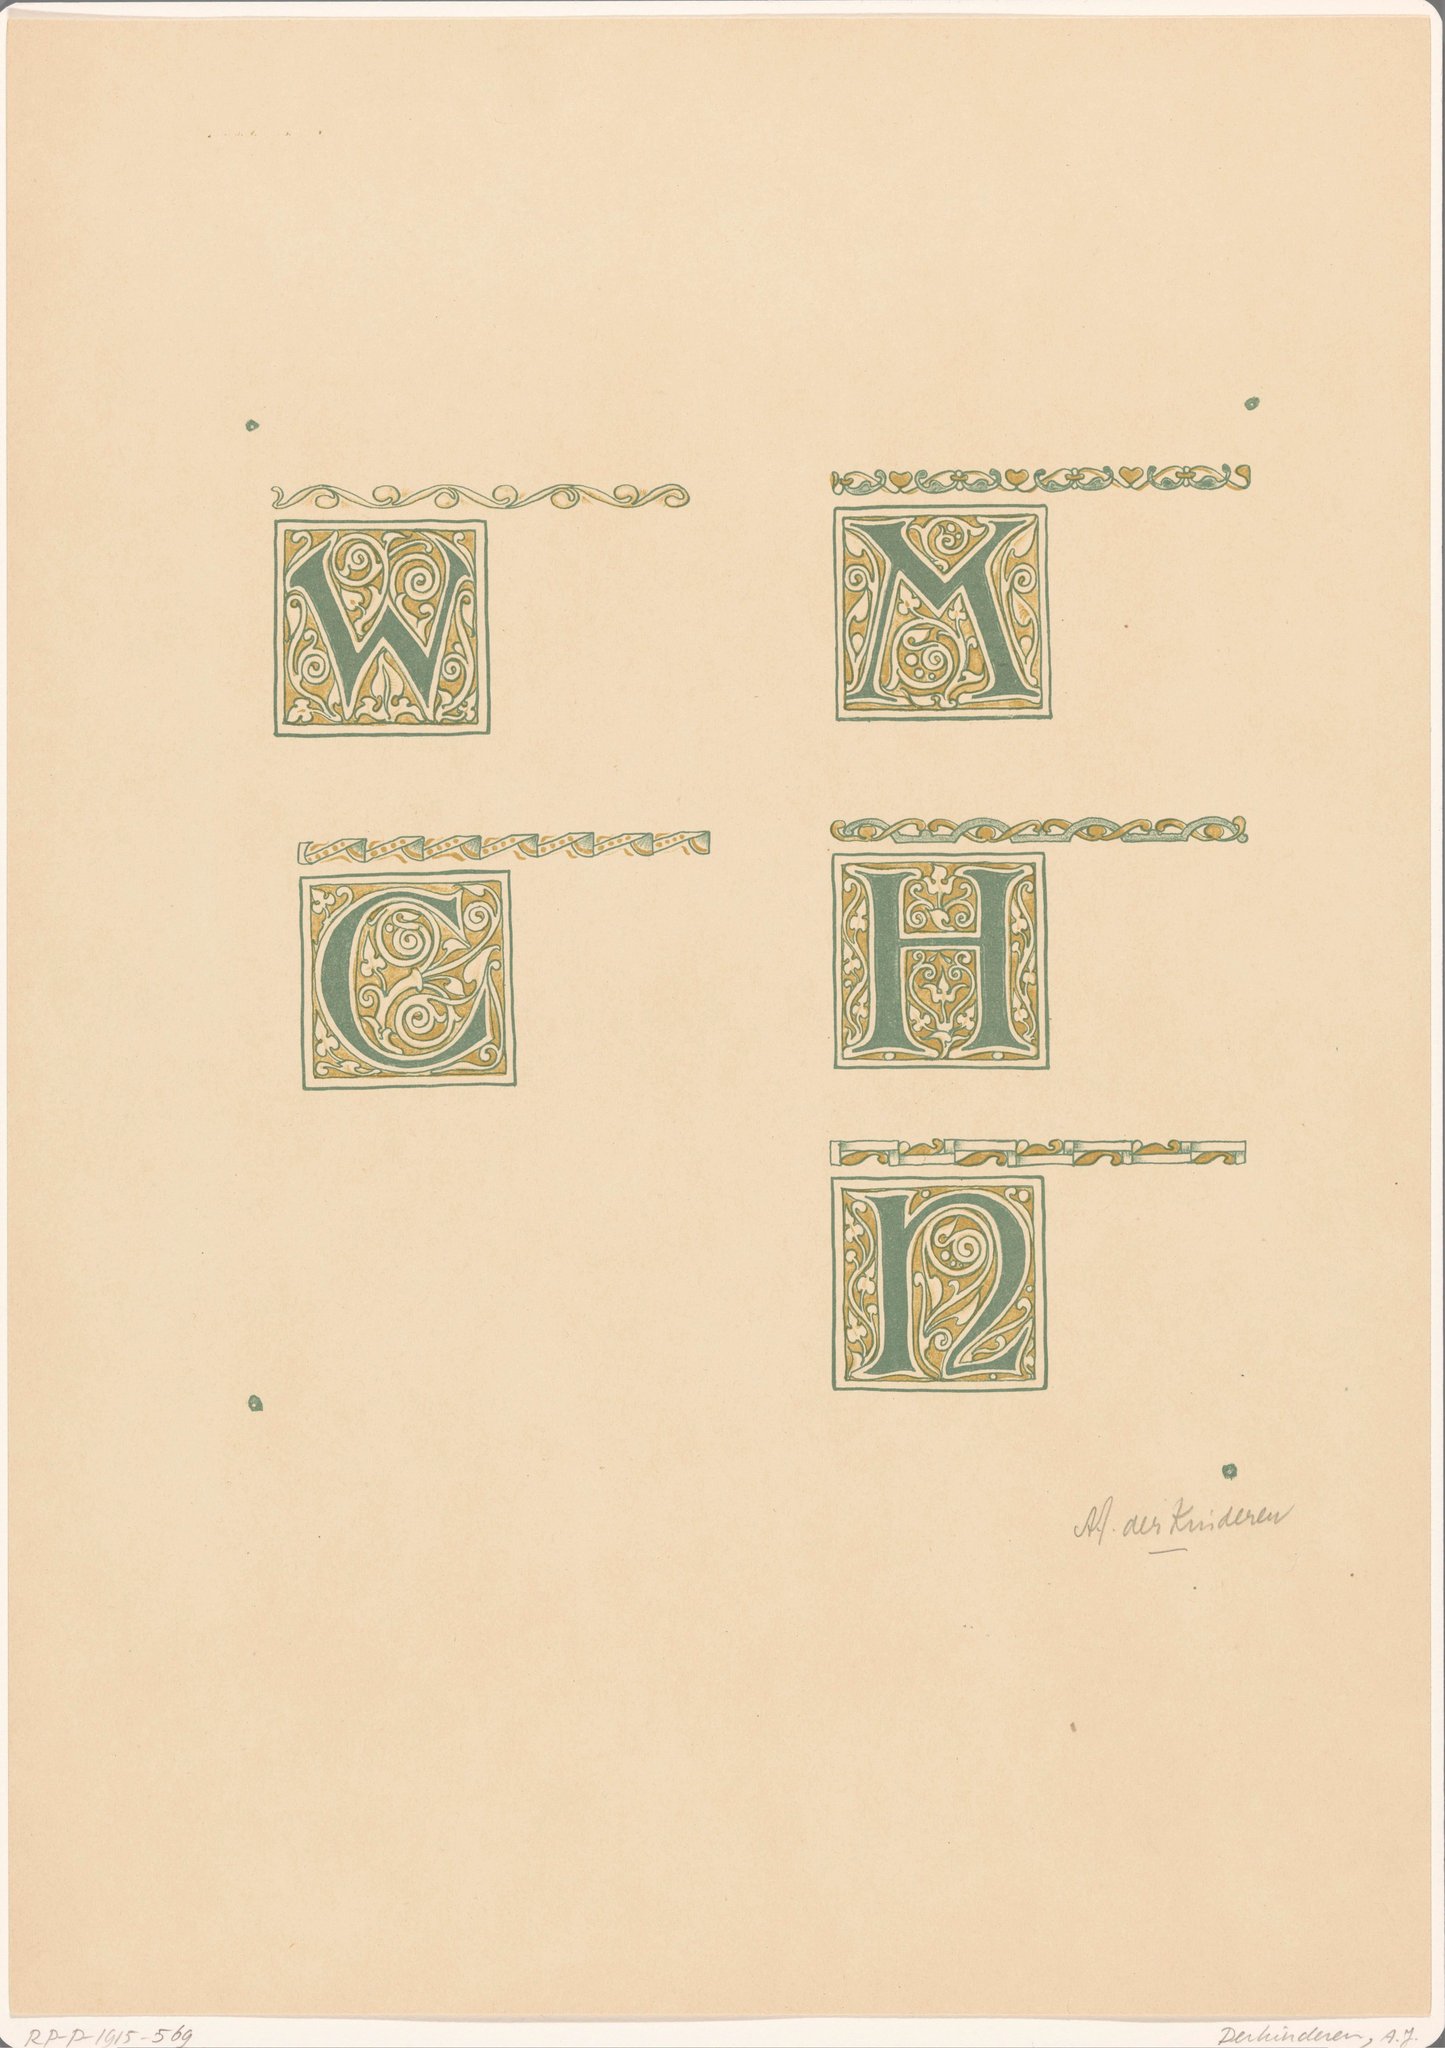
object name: print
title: Hoofdletters C, H, M, N en W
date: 1896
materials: paper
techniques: lithograph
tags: initial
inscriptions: collector's mark: Lugt 2233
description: Prent gebruikt voor: Veth, Jan. Gedenkboek der Hollandsche schilderkunst uit het tydperk van 1860 tot 1890. Amsterdam: Kunsthandel C.M. van Gogh, 1896.